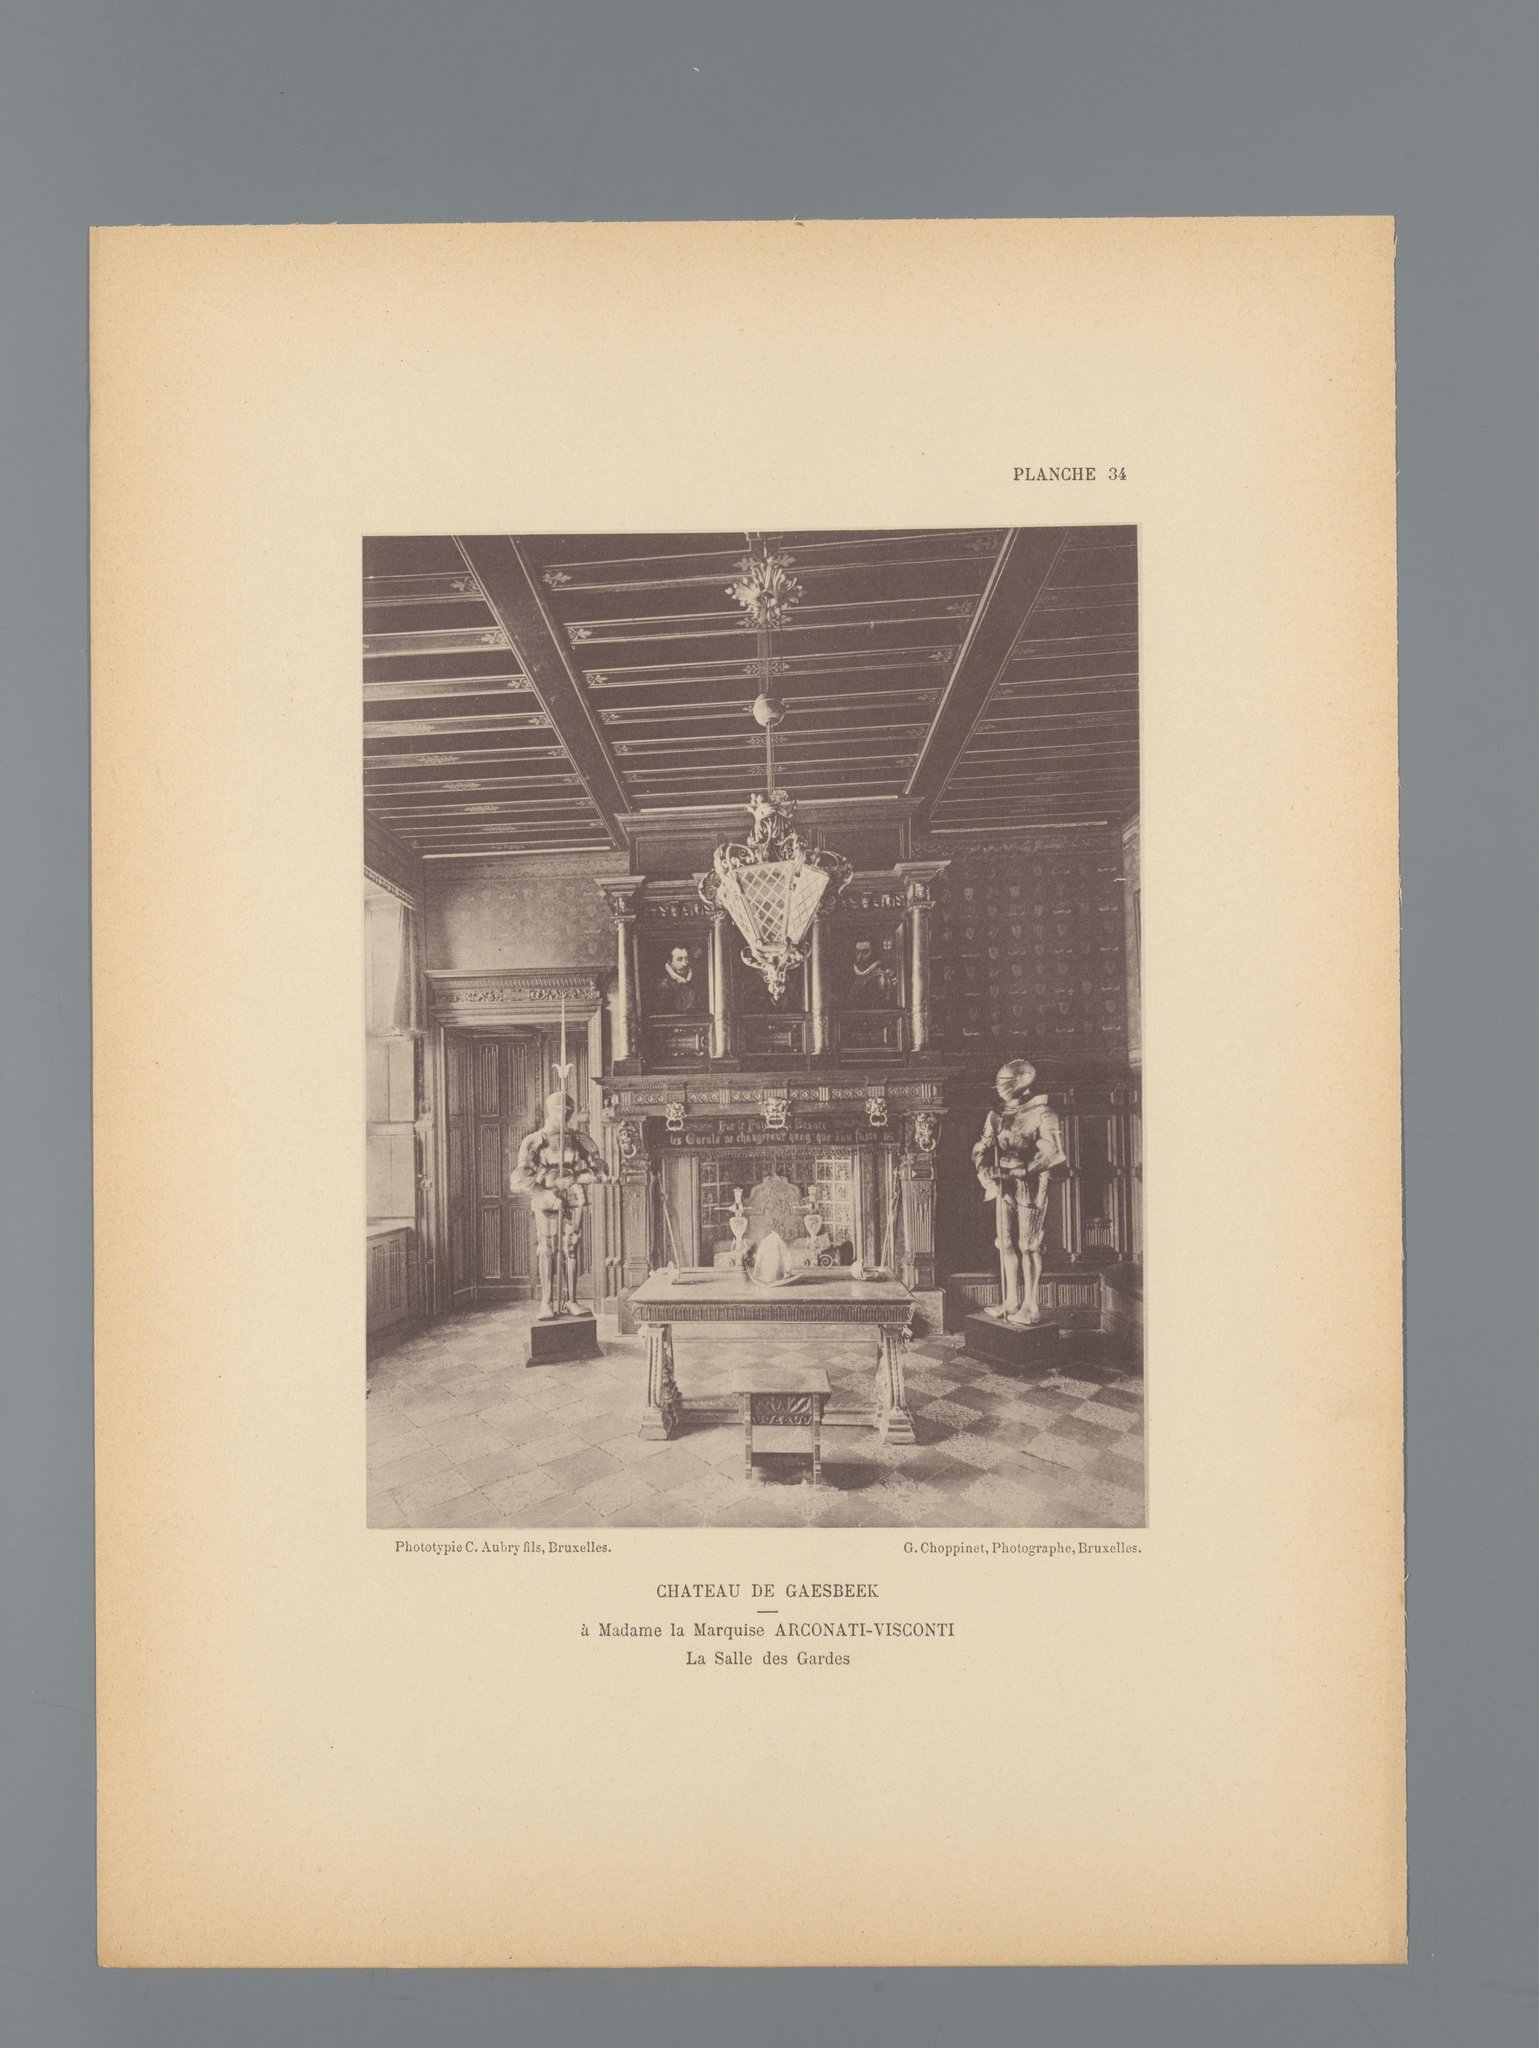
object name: photomechanical print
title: Gezicht op de bewakerszaal van het Kasteel van Gaasbeek, België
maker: gustave choppinet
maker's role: fotograaf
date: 1893-1898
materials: paper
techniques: photograph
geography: kasteel van gaasbeek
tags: castle, interior of the house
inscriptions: number: ‘PLANCHE 34’, inscription: ‘à Madame la Marquise ARCONATI-VISCONTI/ La Salle des Gardes’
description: Deze prent maakt deel uit van een omslag met 89 prenten en 5 tekstbladen.